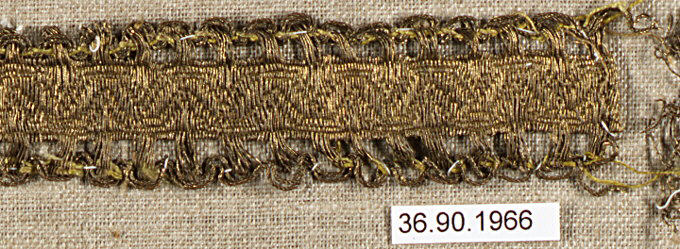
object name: piece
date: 1801-1900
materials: metal thread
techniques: lace